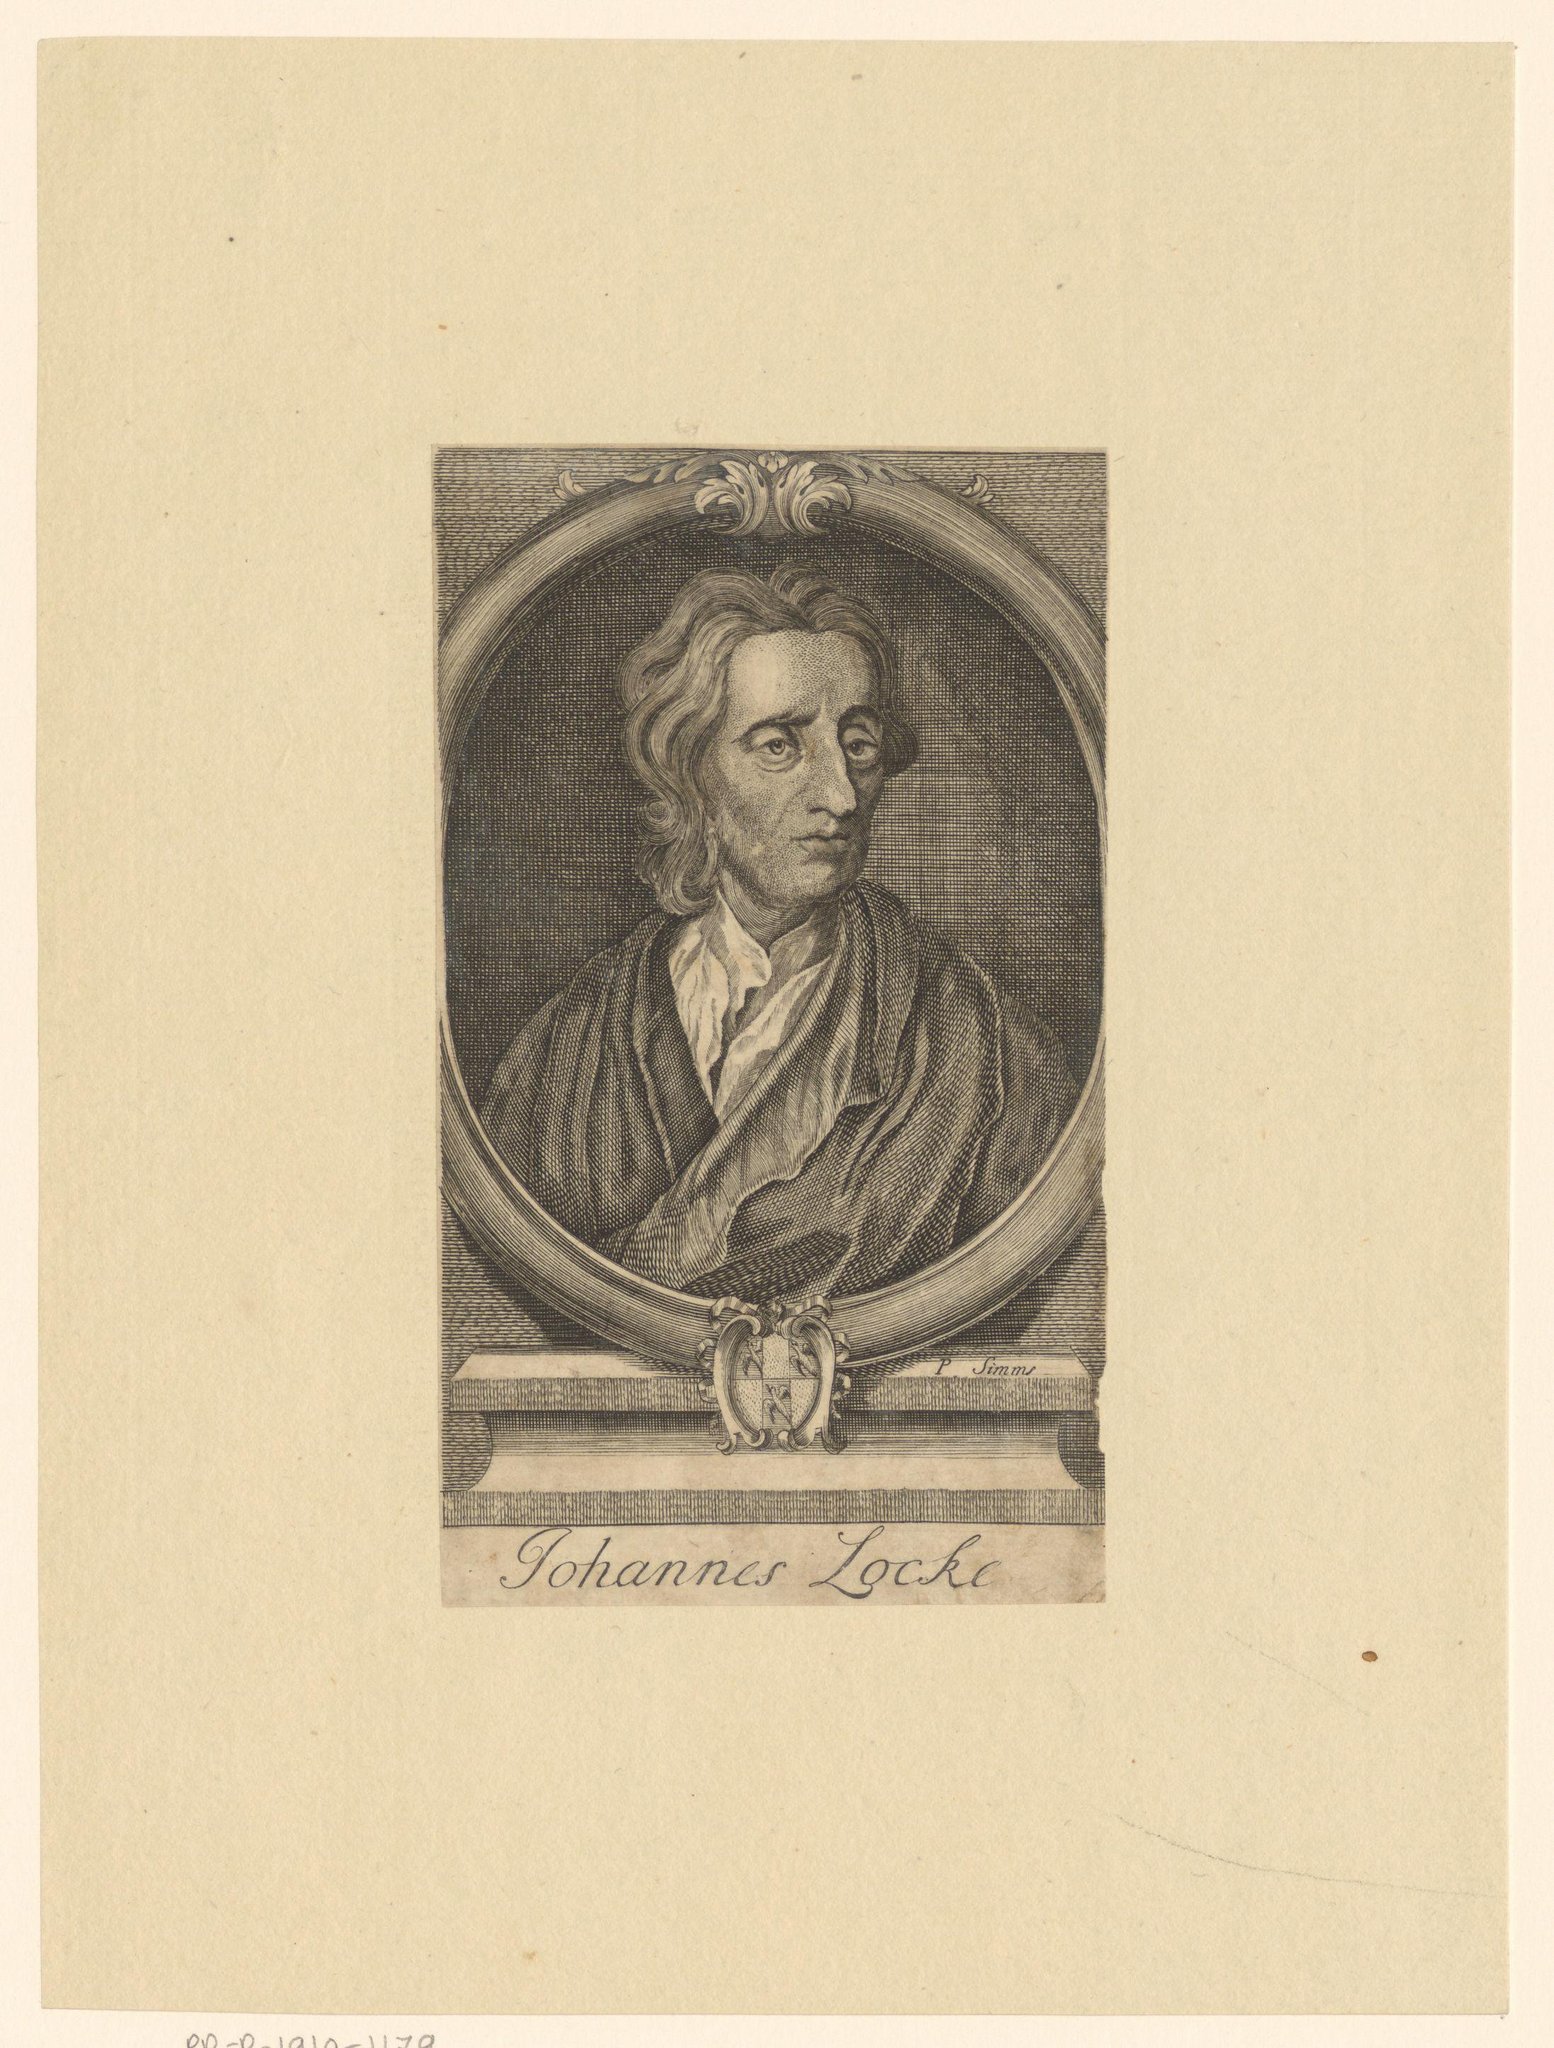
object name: print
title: Portret van John Locke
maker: philip simms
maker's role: print maker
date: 1725-1749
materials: paper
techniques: engraving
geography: dublin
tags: politician, physicist, historical persons, scholar, philosopher (+ portrait of scholar, scientist)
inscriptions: collector's mark: Lugt 2228